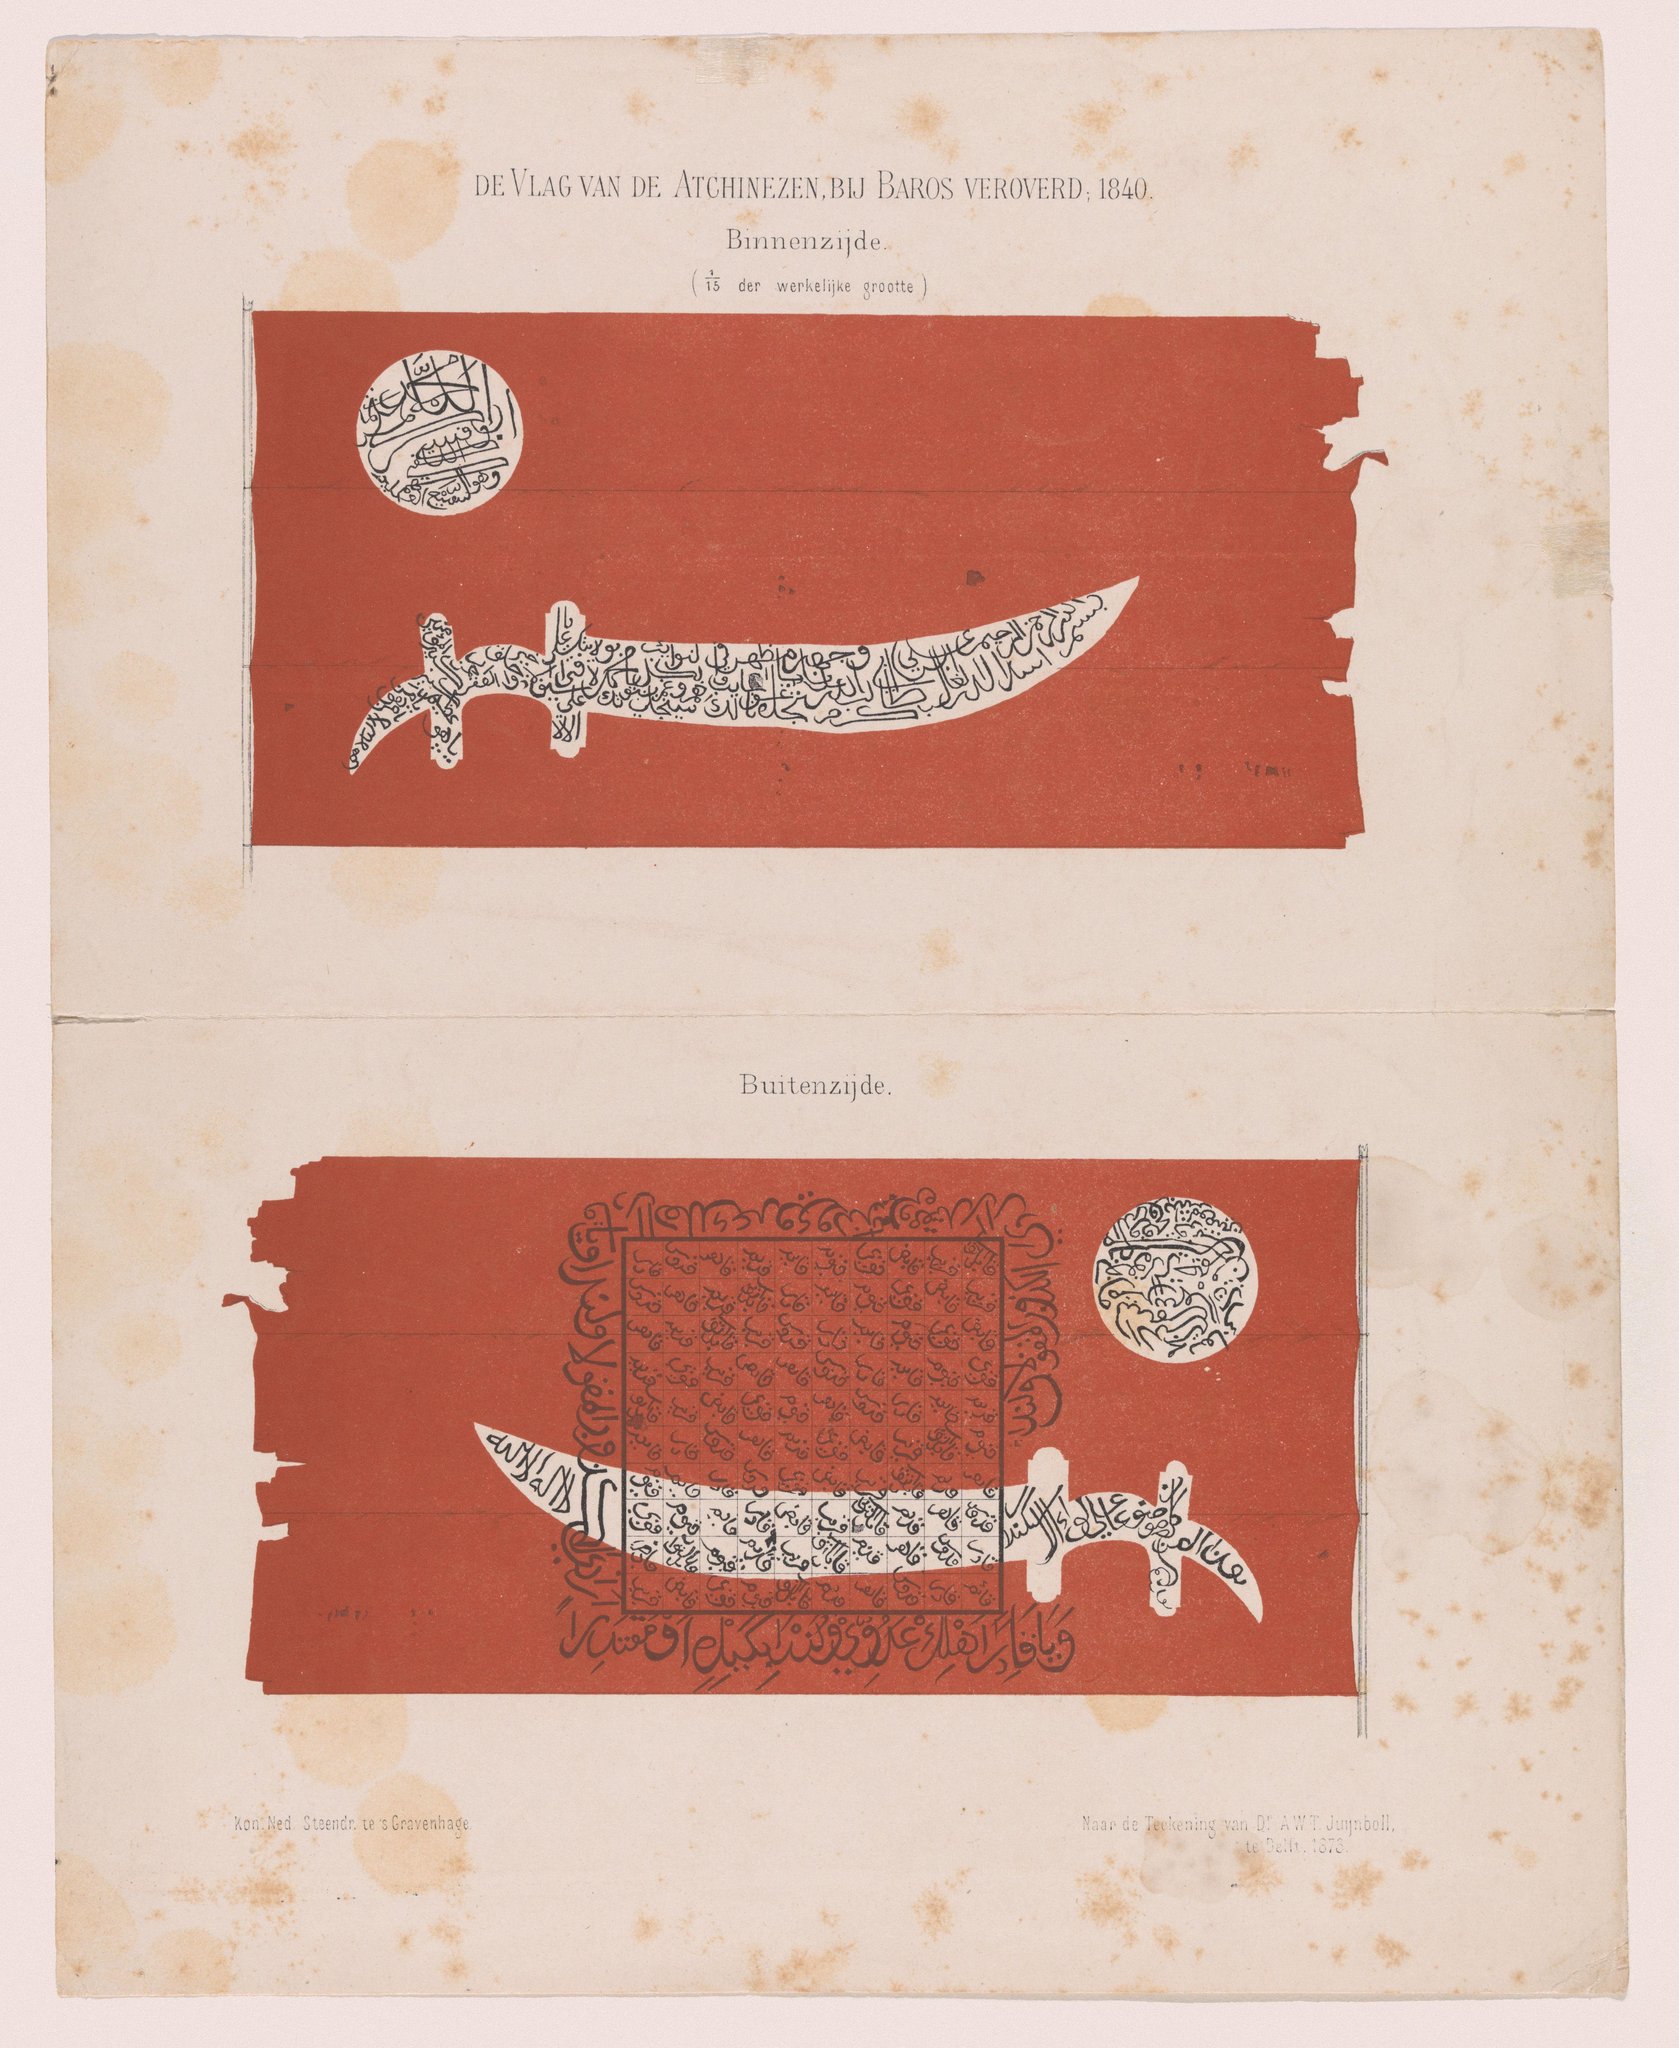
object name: print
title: The Flag of the Acehnese Captured at Baros, 1840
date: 1873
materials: paper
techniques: lithograph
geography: delft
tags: maastricht, flag, colours (as symbol of the state, etc.)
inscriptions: collector's mark: Lugt 2228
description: Dubbelgevouwen blad met op de binnenzijde twee afbeeldingen van de binnen- en buitenzijde van een vlag of banier veroverd bij Baroes tijdens de veldtocht tegen de Atjehse legeraanvoerder Al-Iskander, 1840. Atjehse vlag, met maan en kromzwaard en opschriften in het Arabisch. Op de voorzijde van het blad het verhaal van de verovering van de vlag door Carel Heinrich Bischoff en zijn overlijden op 3 mei 1840. Op de achterzijde een beschrijving van de vlag en de opschriften.